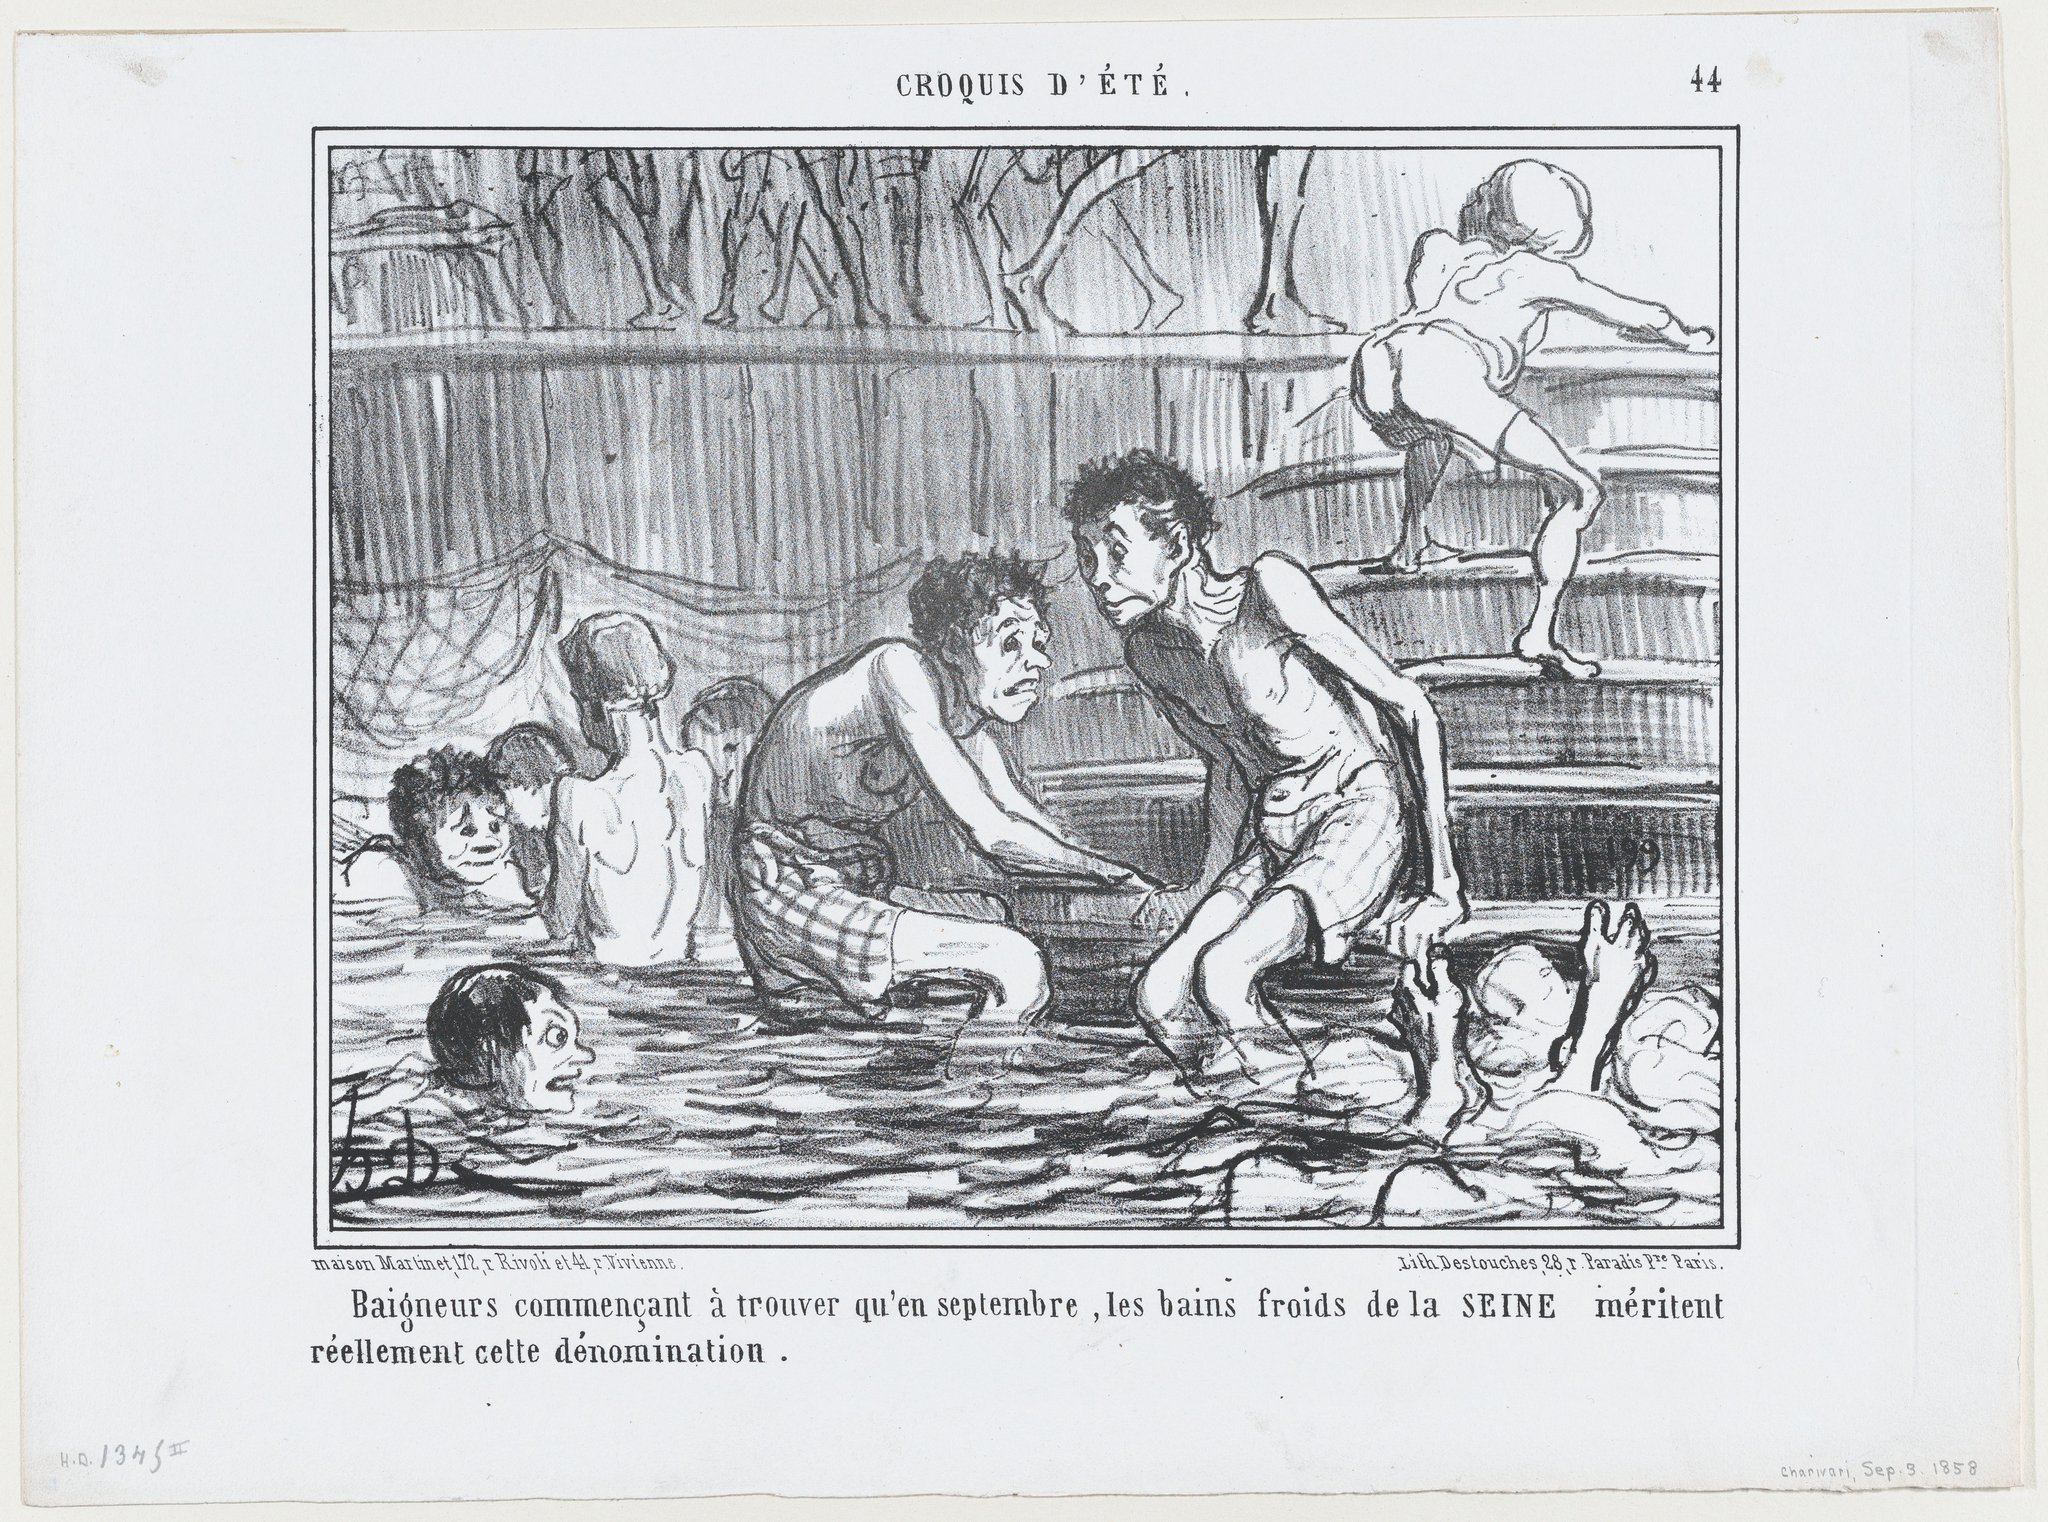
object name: print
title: Baigneurs commençant à trouver qu'en septembre..., from Croquis d'Été, published in Le Charivari, September 3, 1858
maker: honoré daumier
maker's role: artist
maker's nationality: french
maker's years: 1808-1879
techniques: lithograph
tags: men,bathing